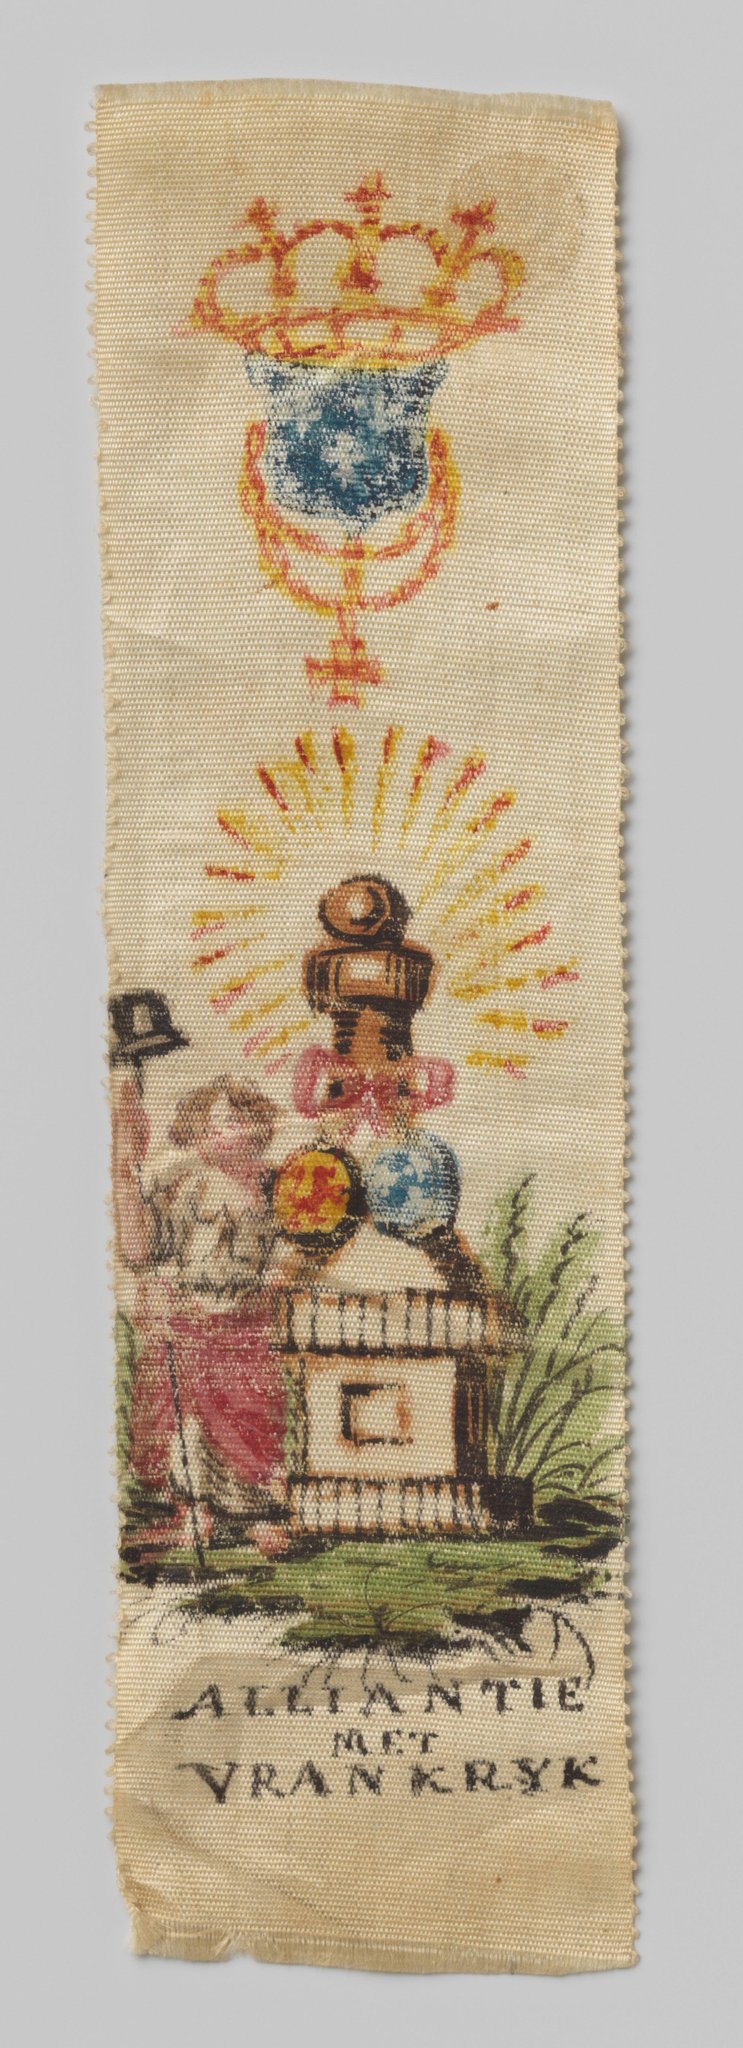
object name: ribbon material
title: Patriottenlintje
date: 1795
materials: silk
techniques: printing, weave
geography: netherlands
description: Lint waarop de Nederlandse maagd met staf en hoed voor een zuil waaraan twee schilden hangen (vergelijk NG-695-17), onder het gekroonde Franse wapen, waaraan een keten en een kruis hangt. Daaronder het opschrift: ALLIANTIE / MET / VRANKRIJK.